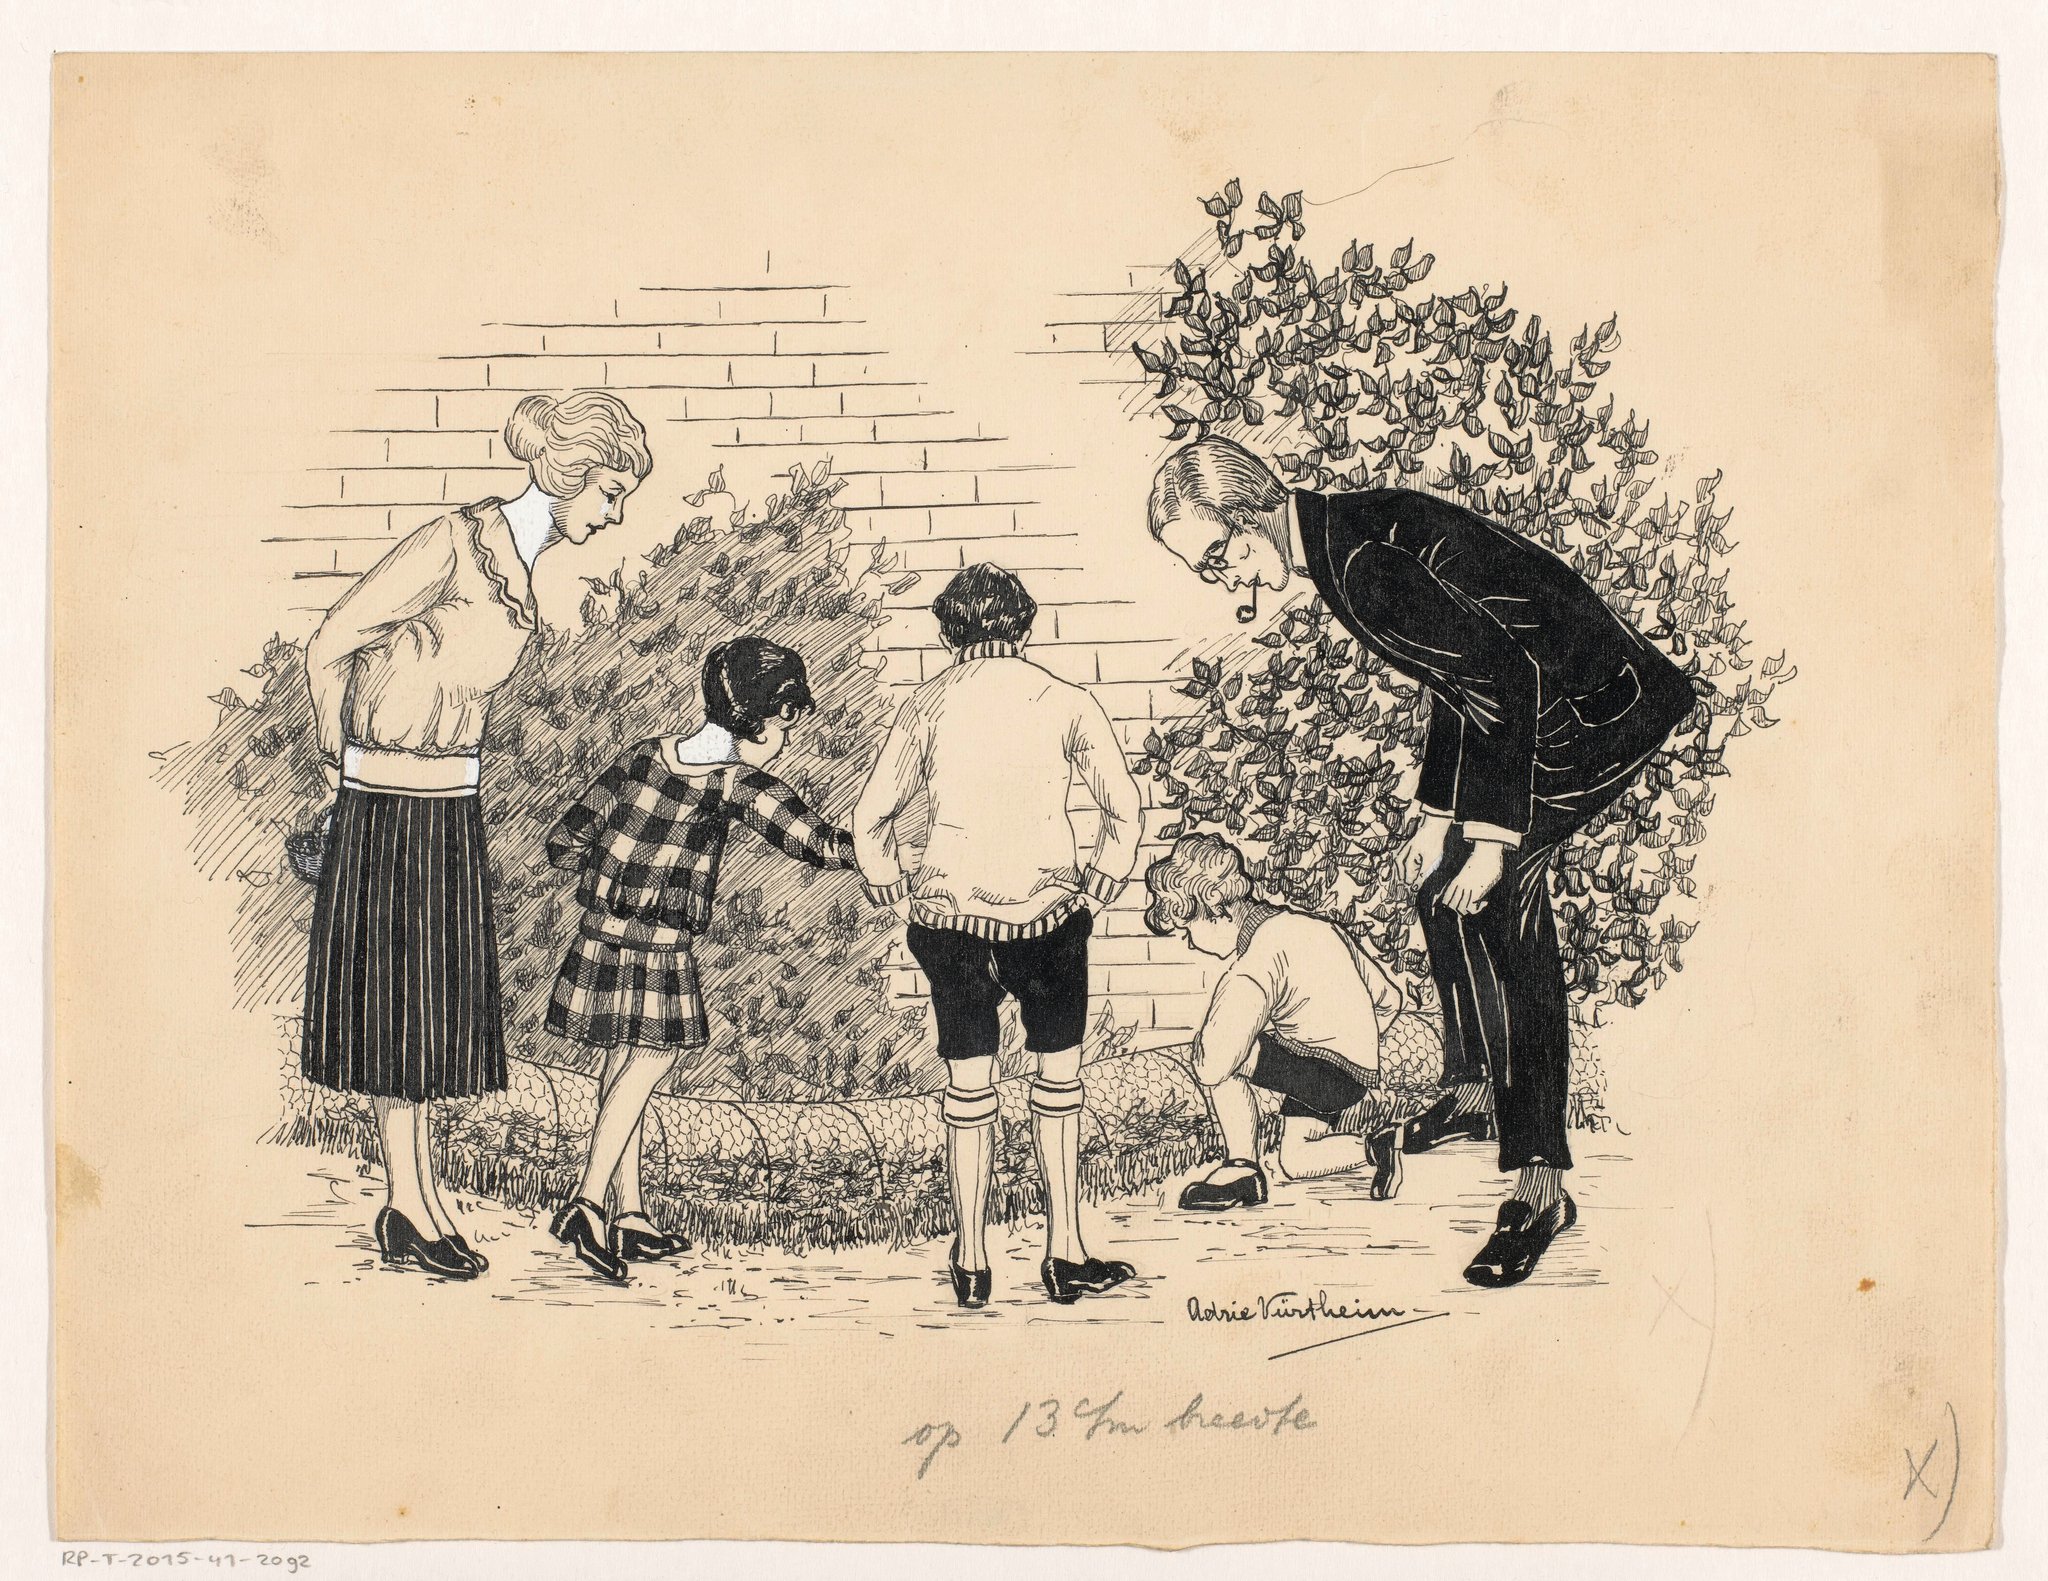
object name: boekillustratie ontwerp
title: Gezin bekijkt een moestuin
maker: adrie vürtheim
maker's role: draughtsman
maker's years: 1907-1995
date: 1917-1970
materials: paint, ink, paper, pencil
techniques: brush, pen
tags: horticulture, vegetable culture, market gardening, family group, especially parents with their child(ren)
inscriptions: signature: ‘Adrie Vürtheim’, annotation: ‘X)’, :, collector's mark: Lugt 2228a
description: Een gezin bestaande uit een vader, moeder en drie kinderen bekijkt een met gaas overdekte moestuin langs een tuinpad.